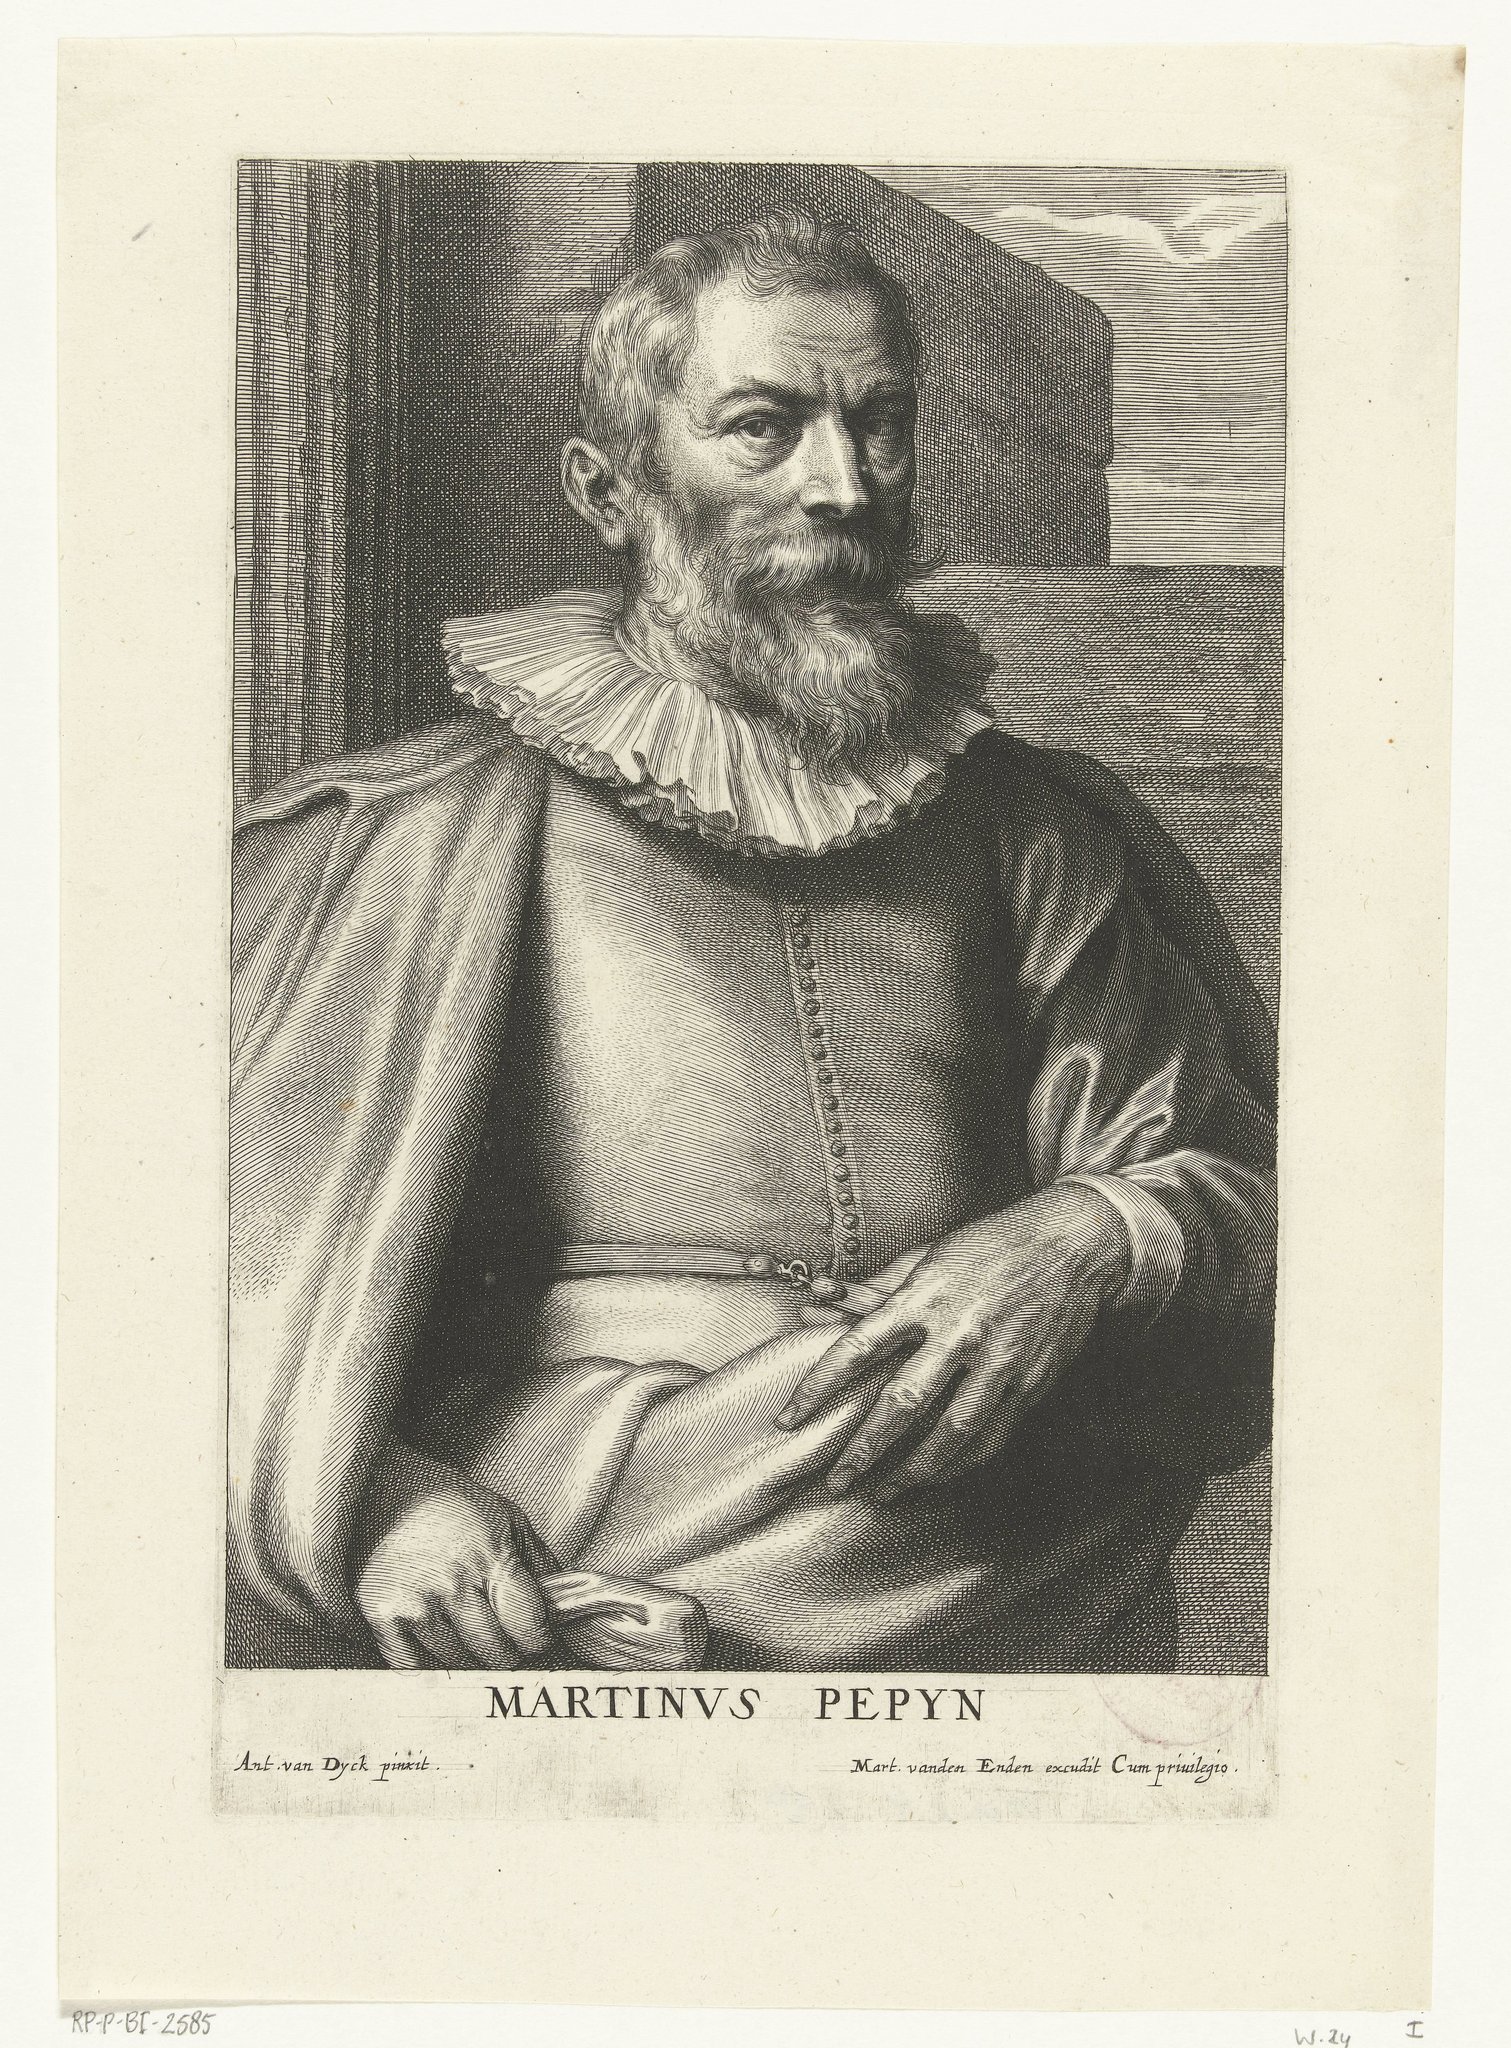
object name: print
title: Martinvs Pepyn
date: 1596-1659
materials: paper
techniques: engraving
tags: artist, historical persons, portrait, self-portrait of painter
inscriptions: collector's mark: Lugt 240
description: Prent naar schilderij van Anthony van Dyck.